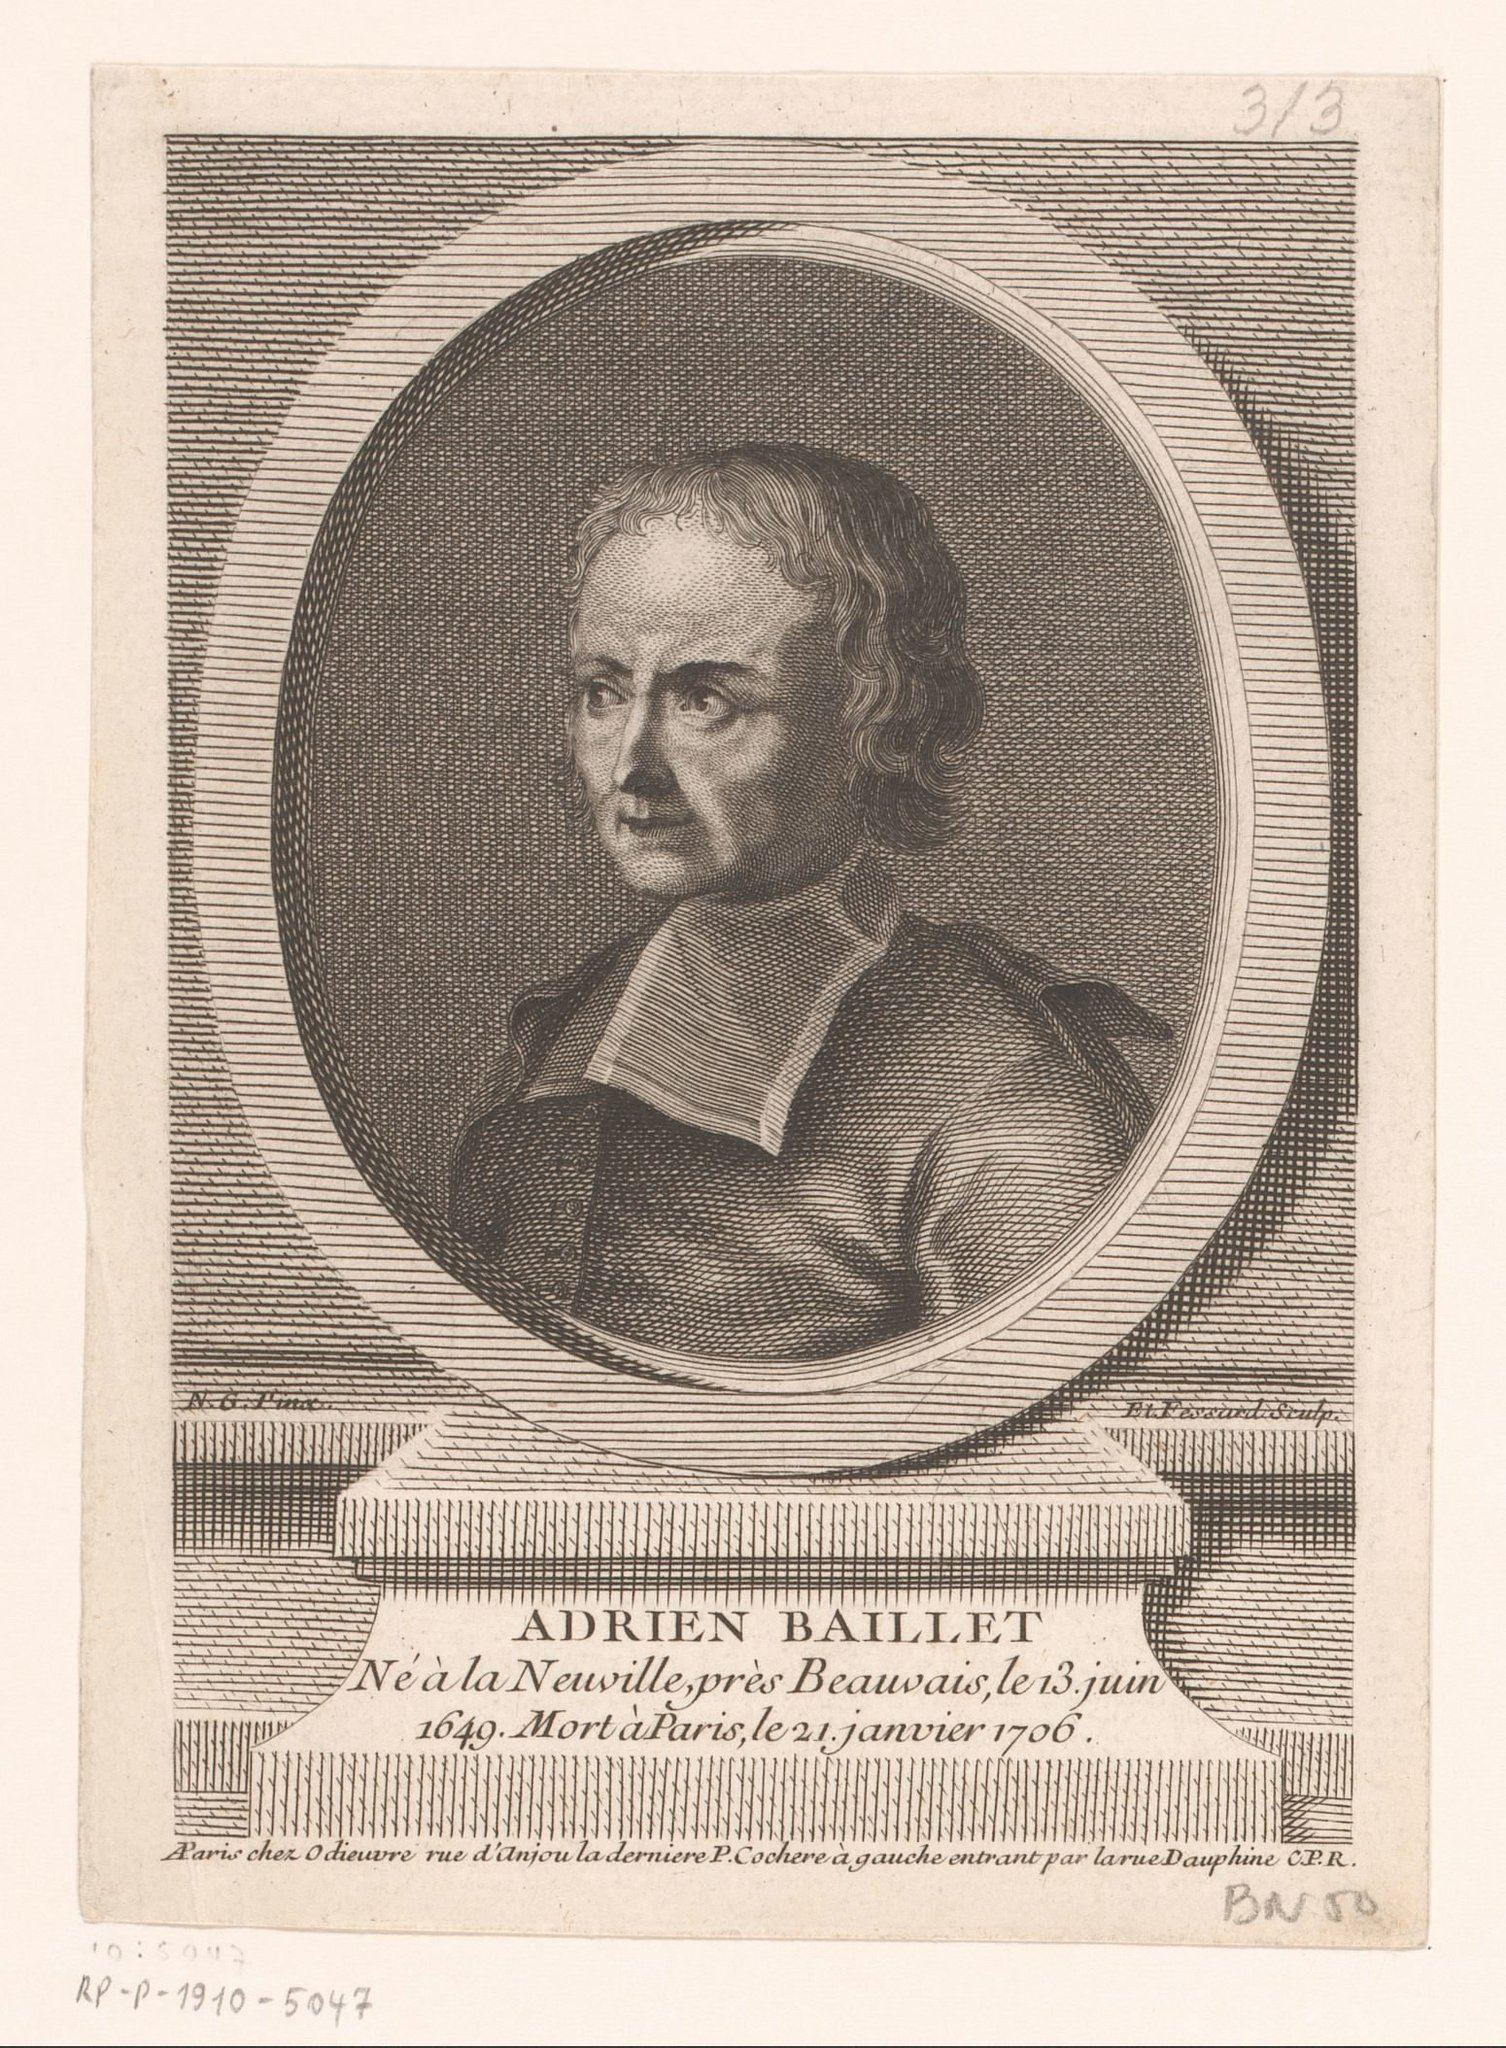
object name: print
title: Portret van Adrien Baillet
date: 1744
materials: paper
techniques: engraving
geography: paris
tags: scholar, philosopher, ornament ~ medallion, historical persons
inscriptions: collector's mark: Lugt 2228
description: Prent uit: Dreux du Radier, Jean-François. L'Europe illustré, contenant l'histoire abregée des souverains, des princes, des prélats, des ministres, (...) en Europe: dans le XVe. siècle compris, jusqu'à présent. Parijs: Michel Odieuvre en Jean-Luc Nyon, 1765, dl. 5.